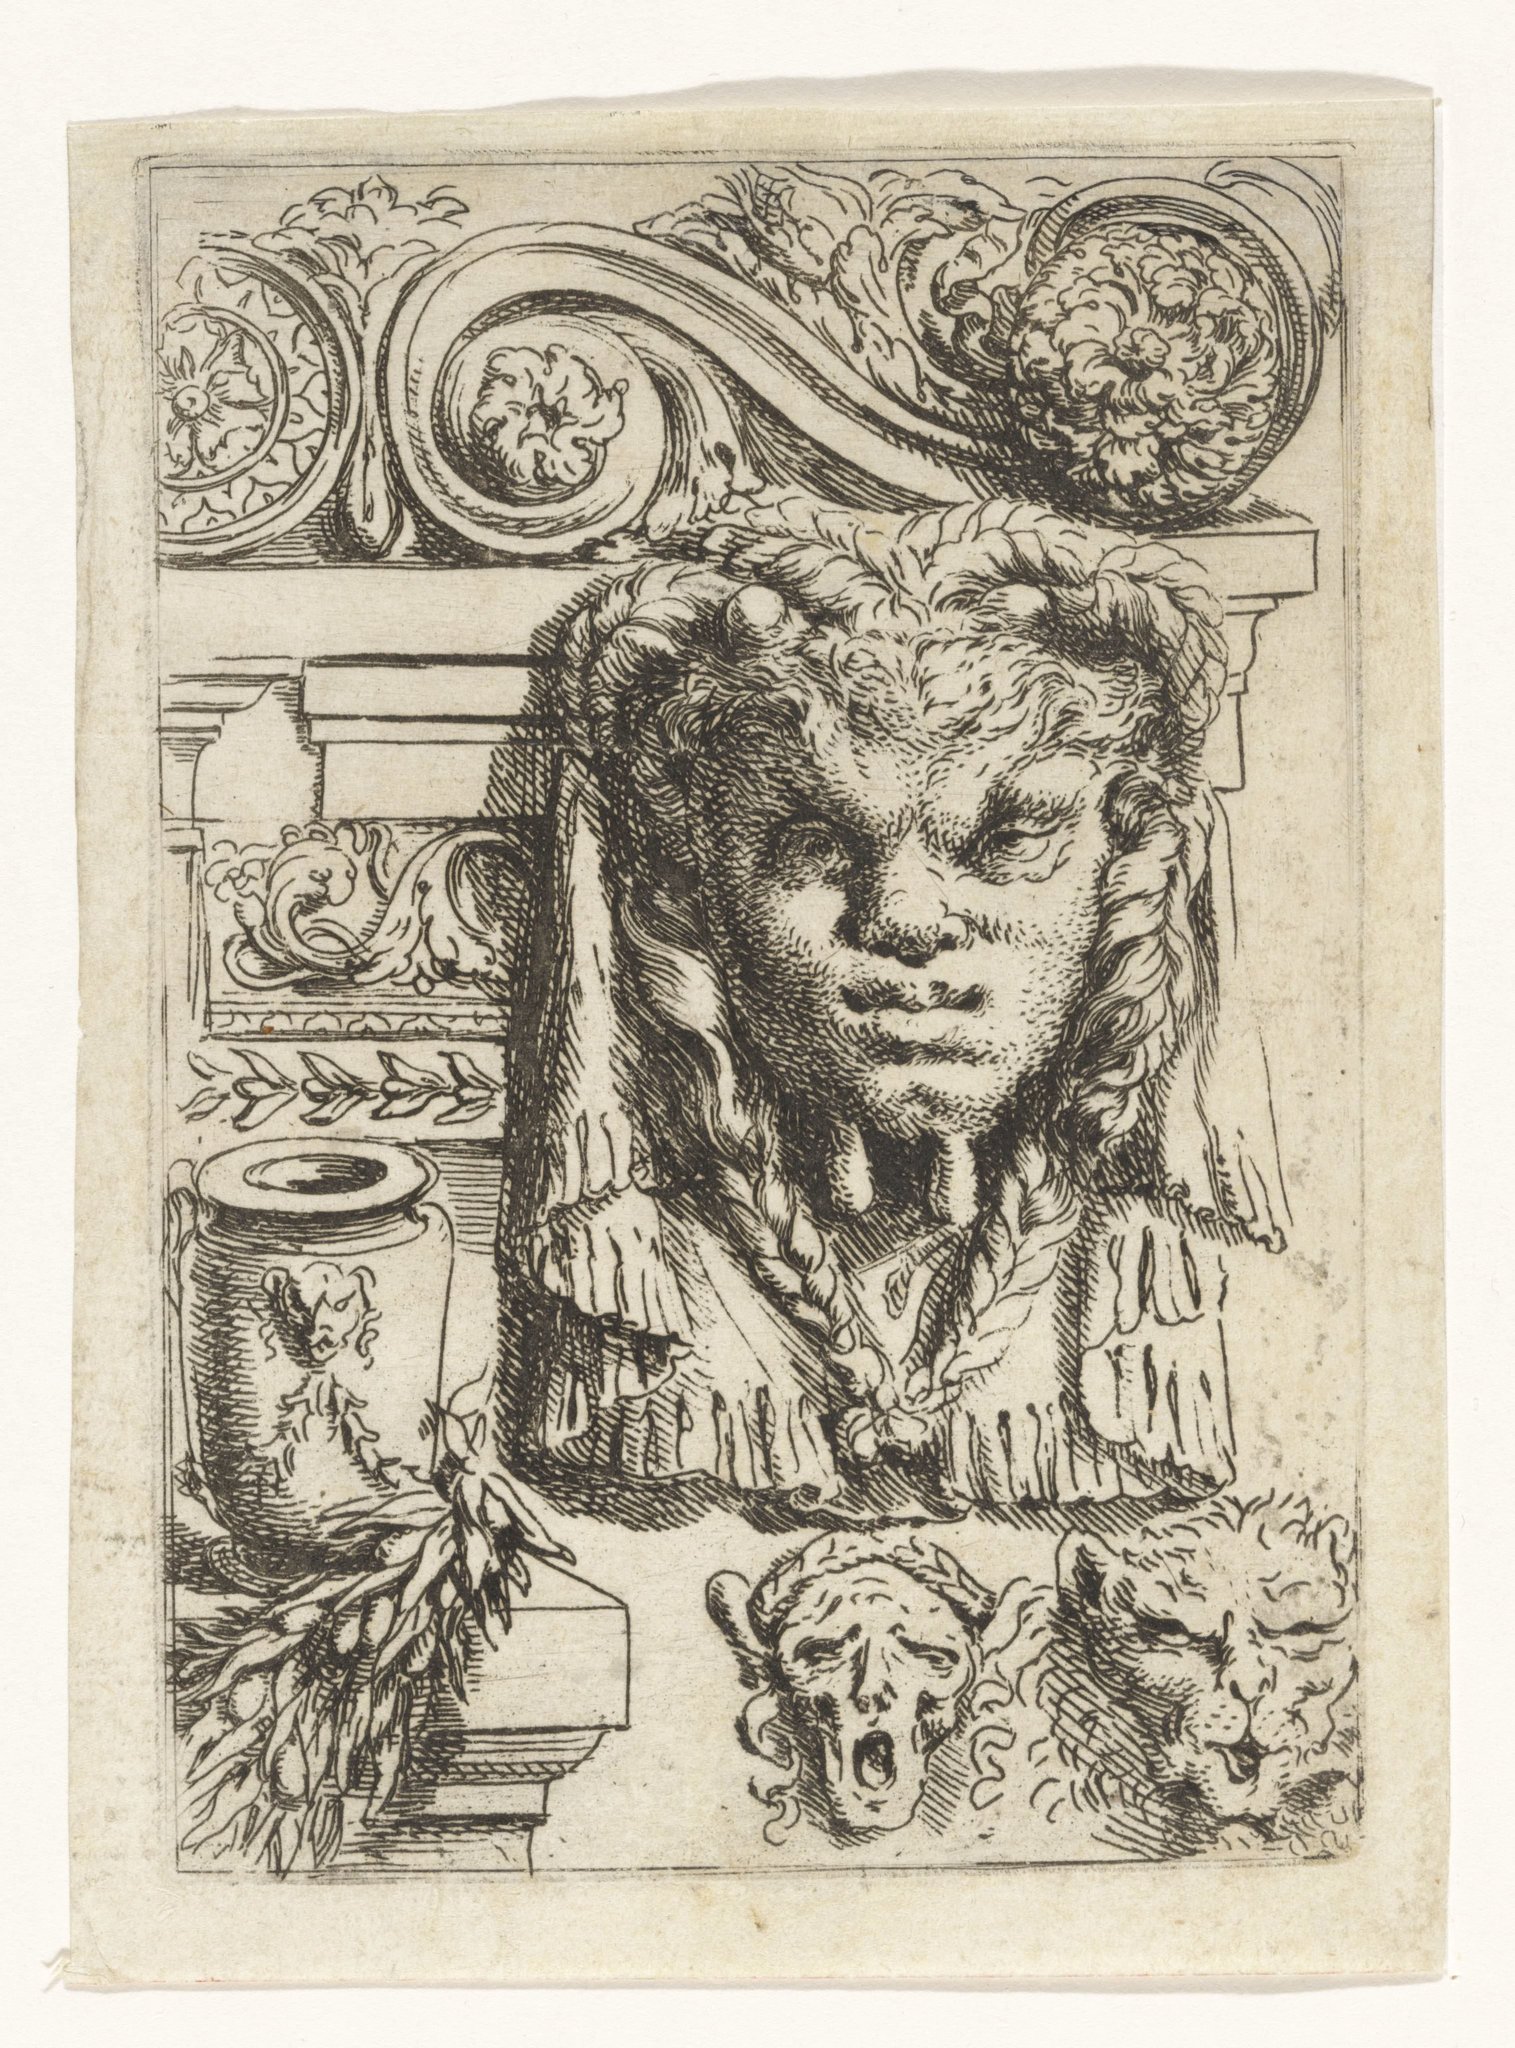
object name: ornament print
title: Divertimenti di Livio Meus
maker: lieven mehus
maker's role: draughtsman, print maker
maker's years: 1630-1691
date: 1650-1671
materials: paper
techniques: etching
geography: low countries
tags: mask, mascaron ~ ornament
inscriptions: collector's mark: Lugt 2760, collector's mark: Lugt 2228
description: Onderdeel serie van vijf ornamentprenten met titelblad.